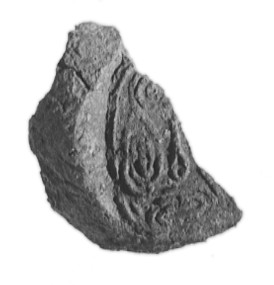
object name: sealing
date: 2030-1640 BCE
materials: clay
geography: egypt